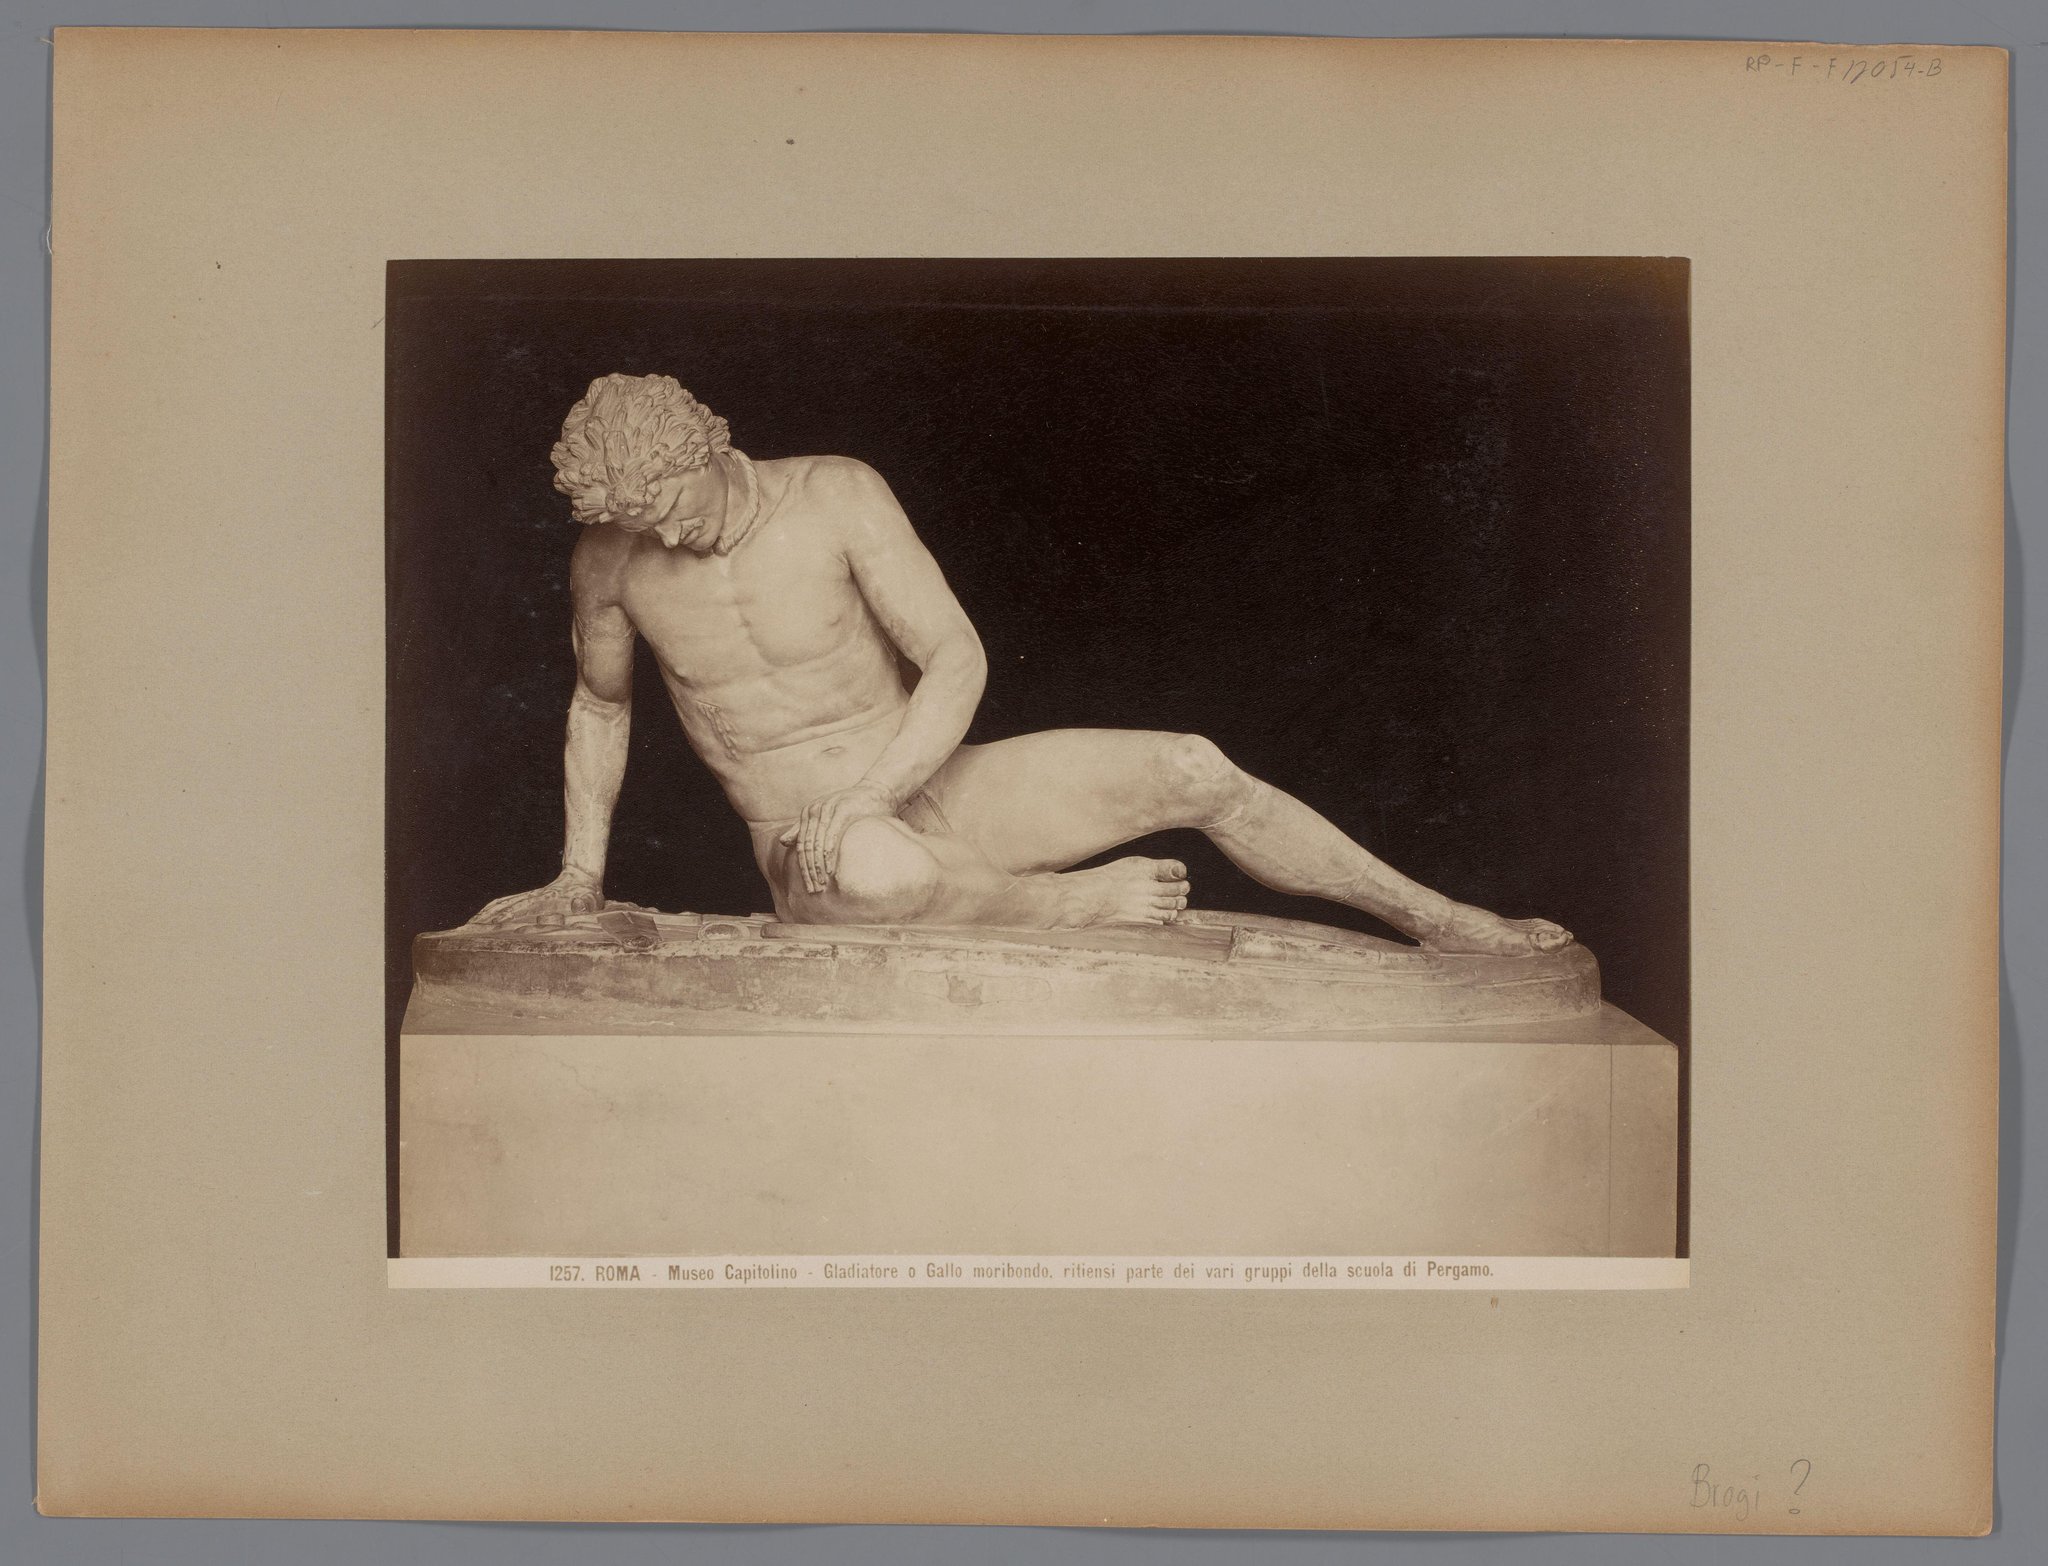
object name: photograph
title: Roma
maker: Anonymous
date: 1851-1900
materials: cardboard, paper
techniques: albumen print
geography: rome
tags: piece of sculpture, reproduction of a piece of sculpture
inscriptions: number: ‘1257.’, inscription: ‘Brogi?’